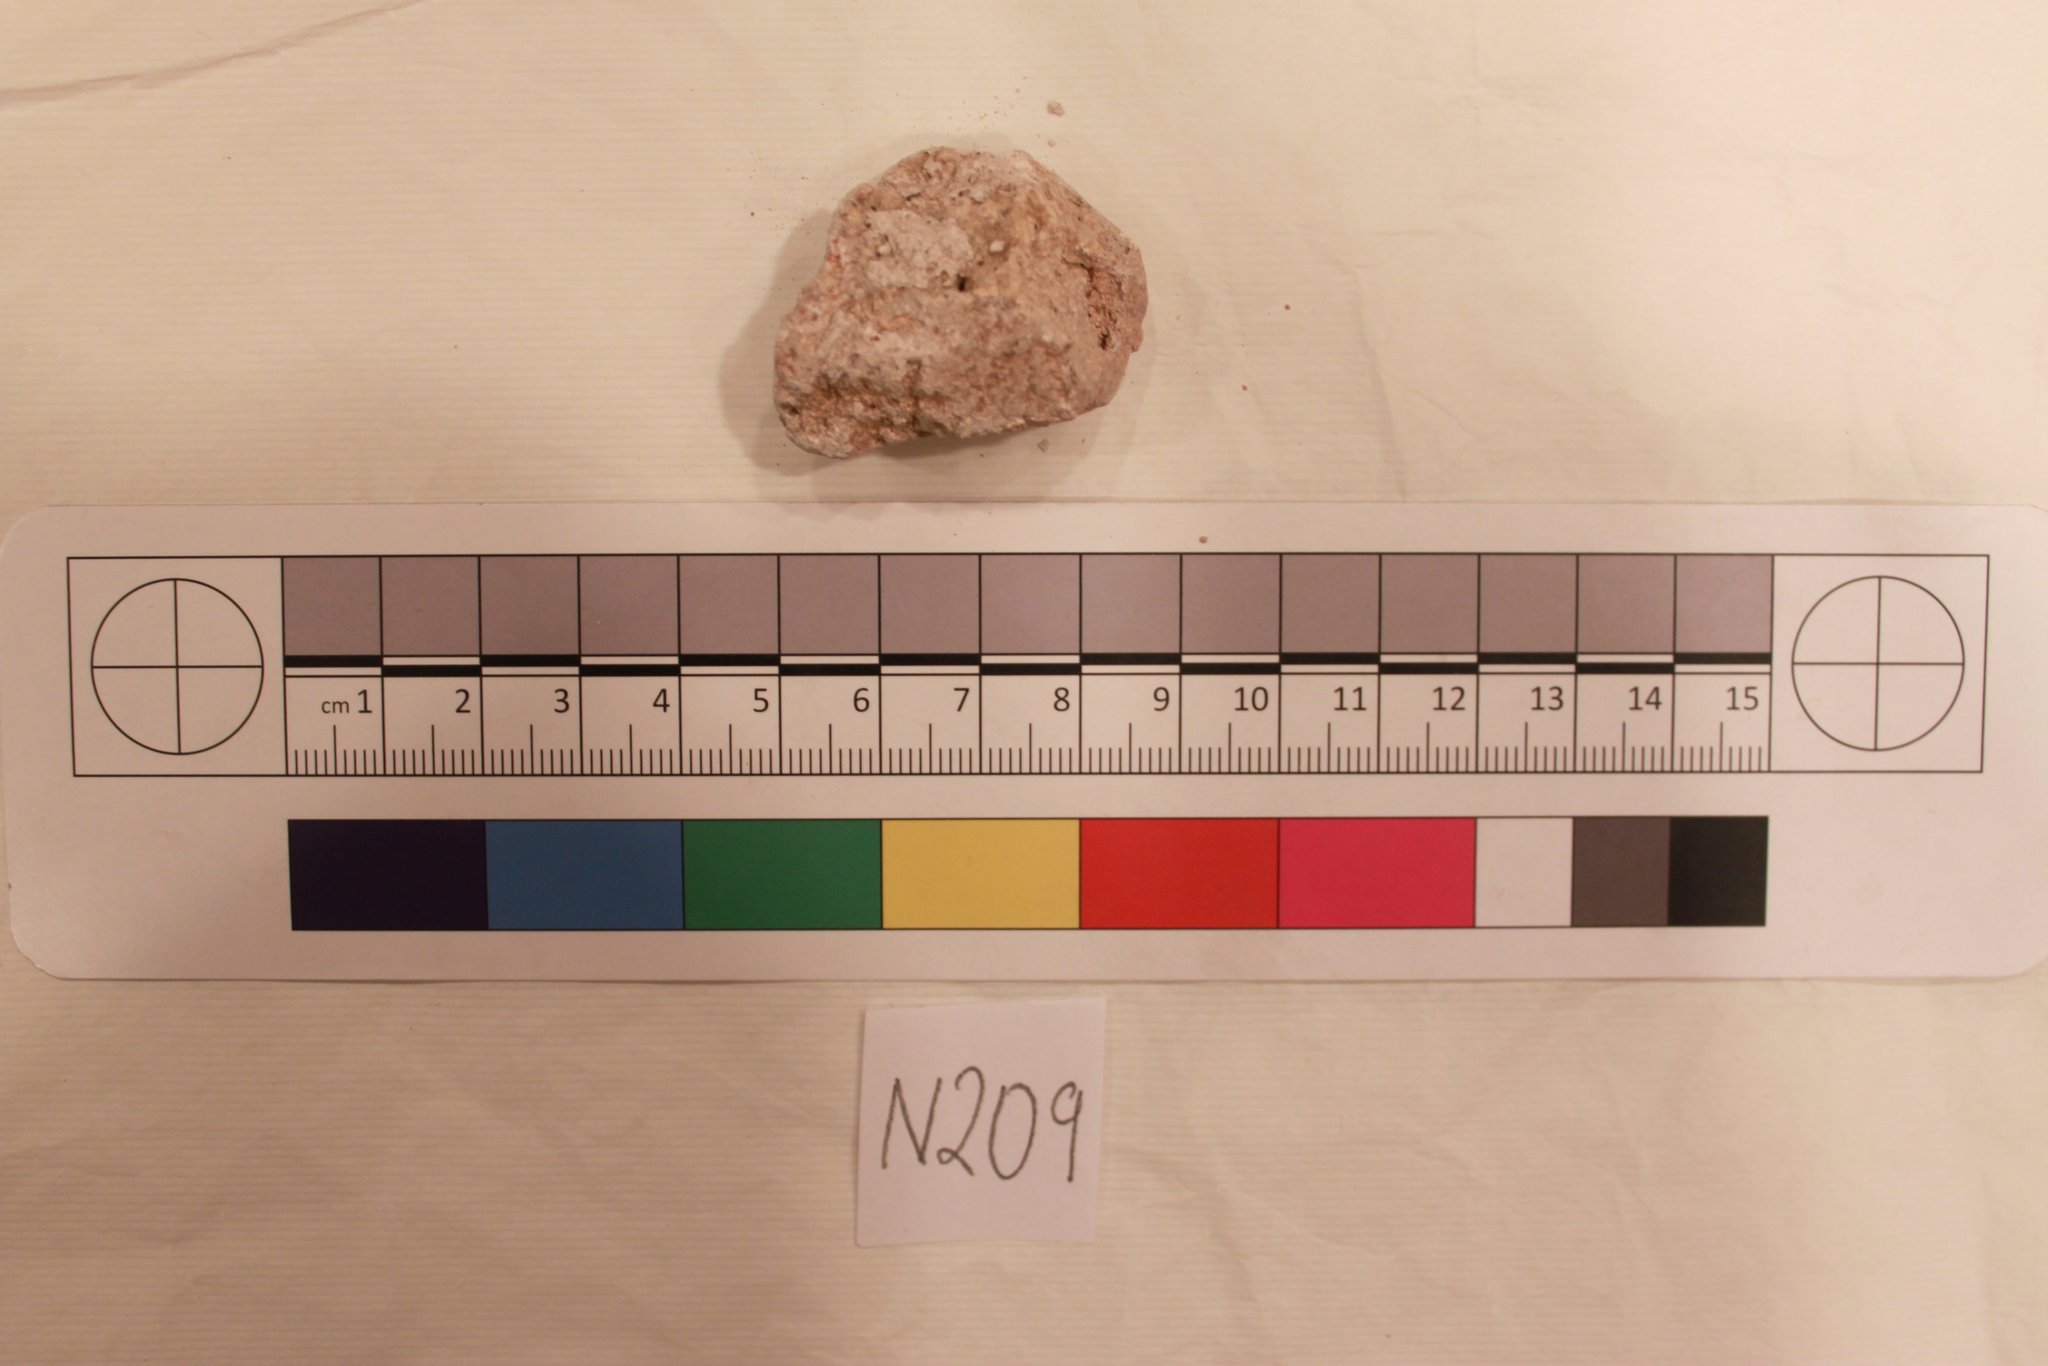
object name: fragment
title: Stucco Fragment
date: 701-1200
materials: plaster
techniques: carving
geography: iran